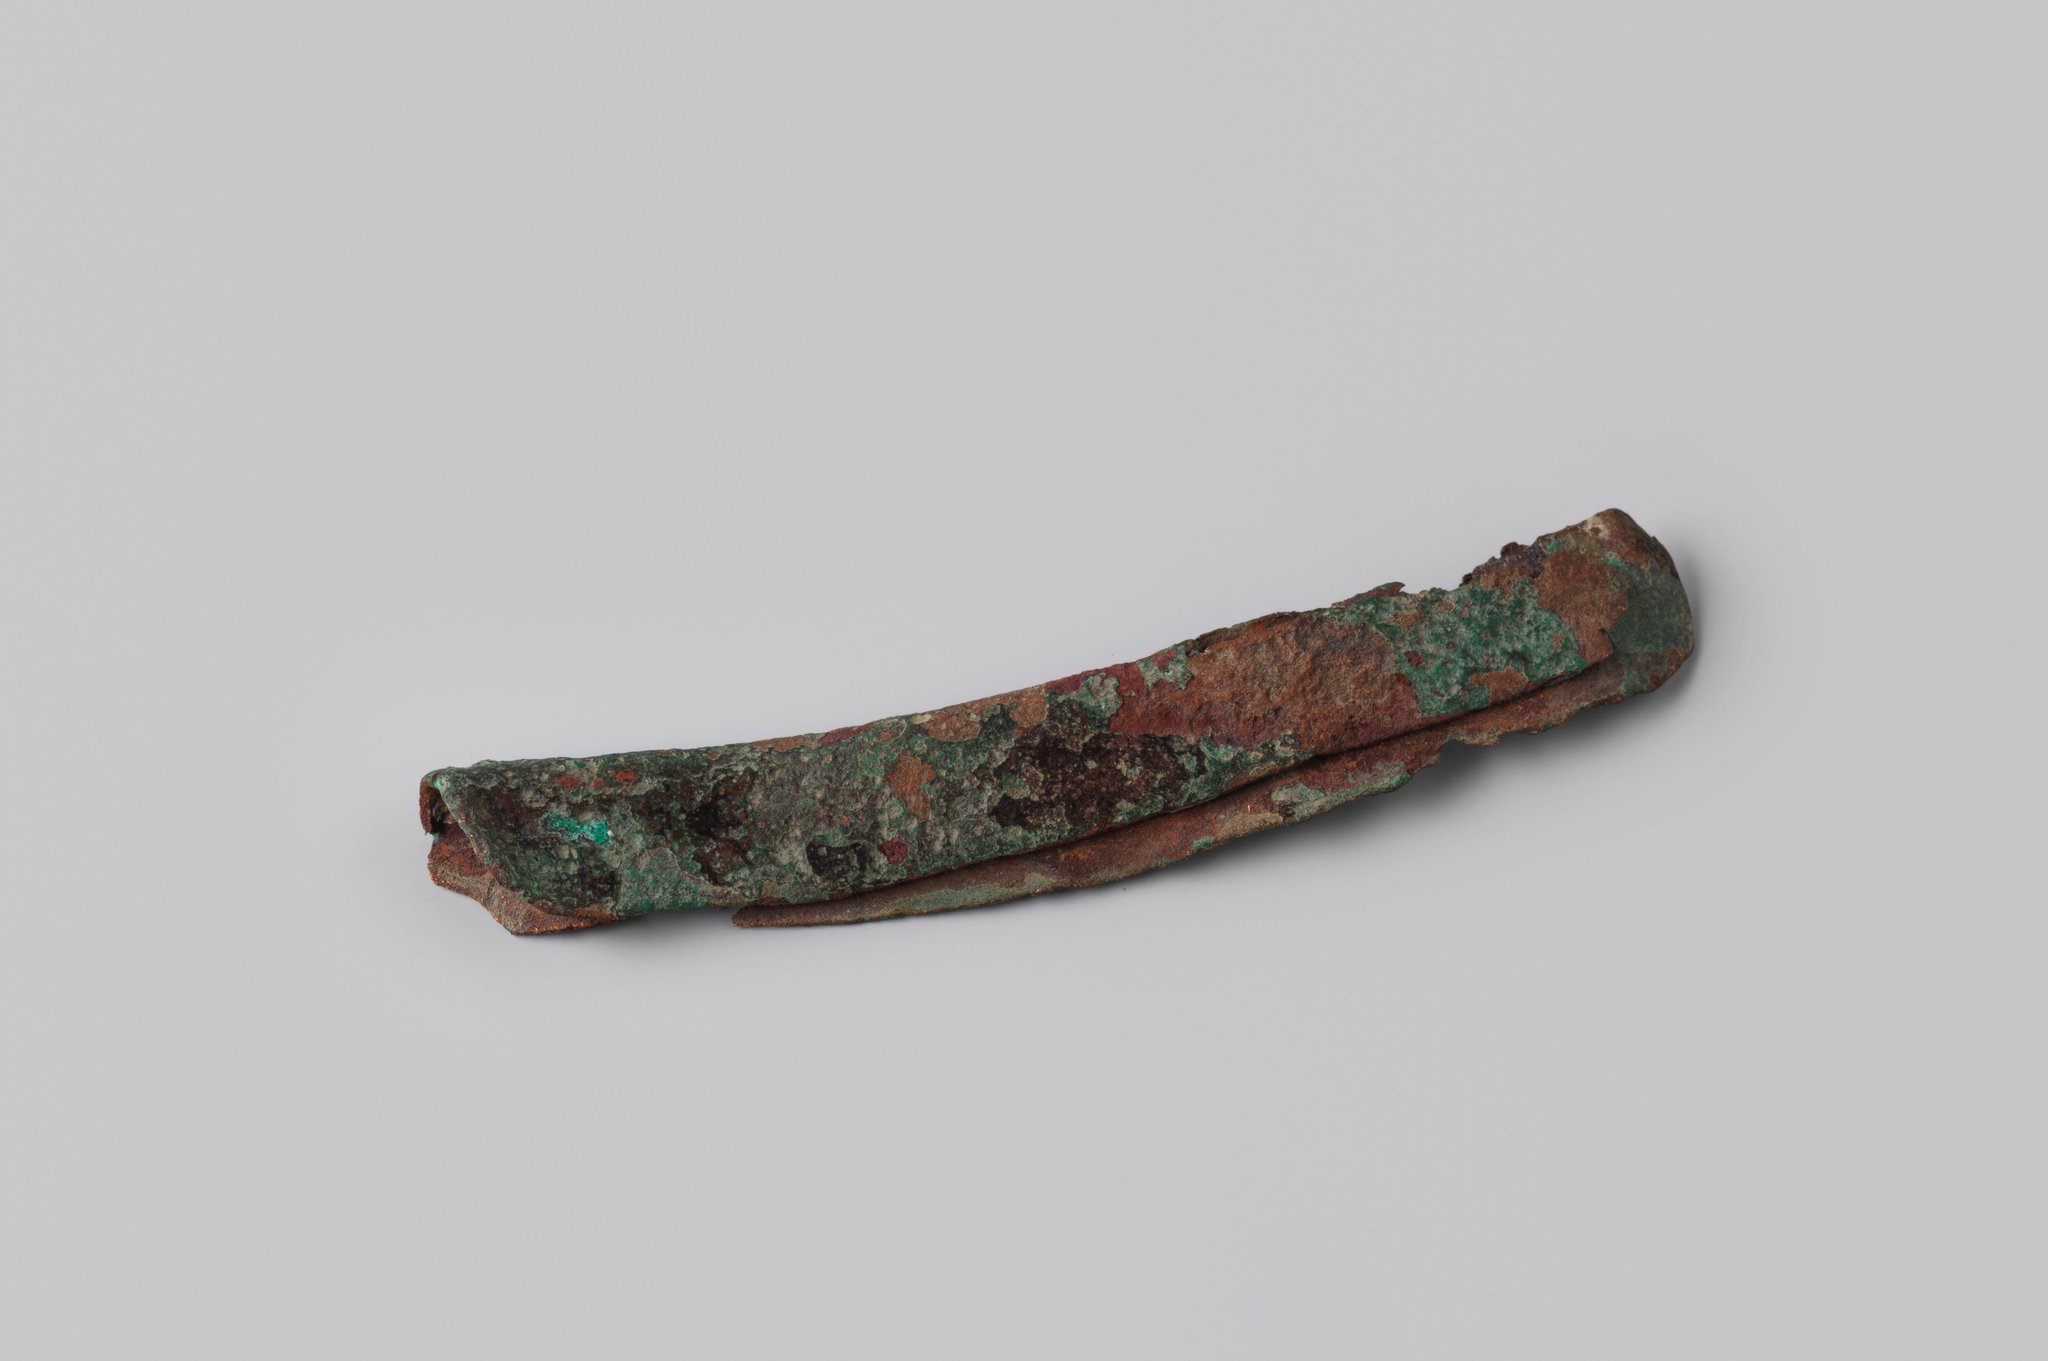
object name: fragment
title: Fragment van koper uit het wrak van de Oost-Indiëvaarder Hollandia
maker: Anonymous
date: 1700-1743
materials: copper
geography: netherlands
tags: verenigde oostindische compagnie, hollandia (schip), annet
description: Varied parts or fragments, strips and strip-shaped fragments; fragm.